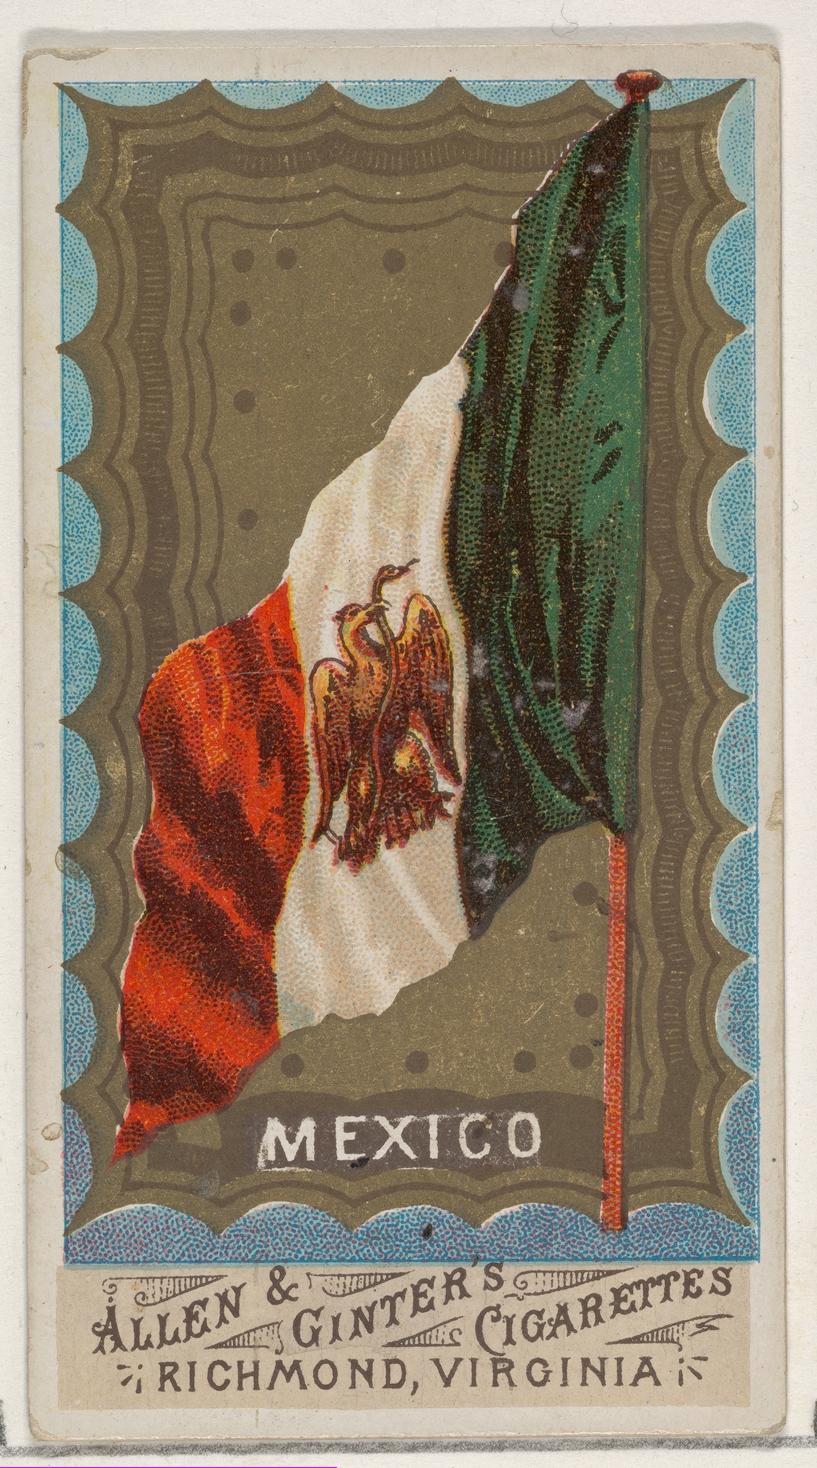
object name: print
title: Mexico, from Flags of All Nations, Series 1 (N9) for Allen & Ginter Cigarettes Brands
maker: allen & ginter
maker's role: publisher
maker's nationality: american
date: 1887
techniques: color lithograph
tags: flags